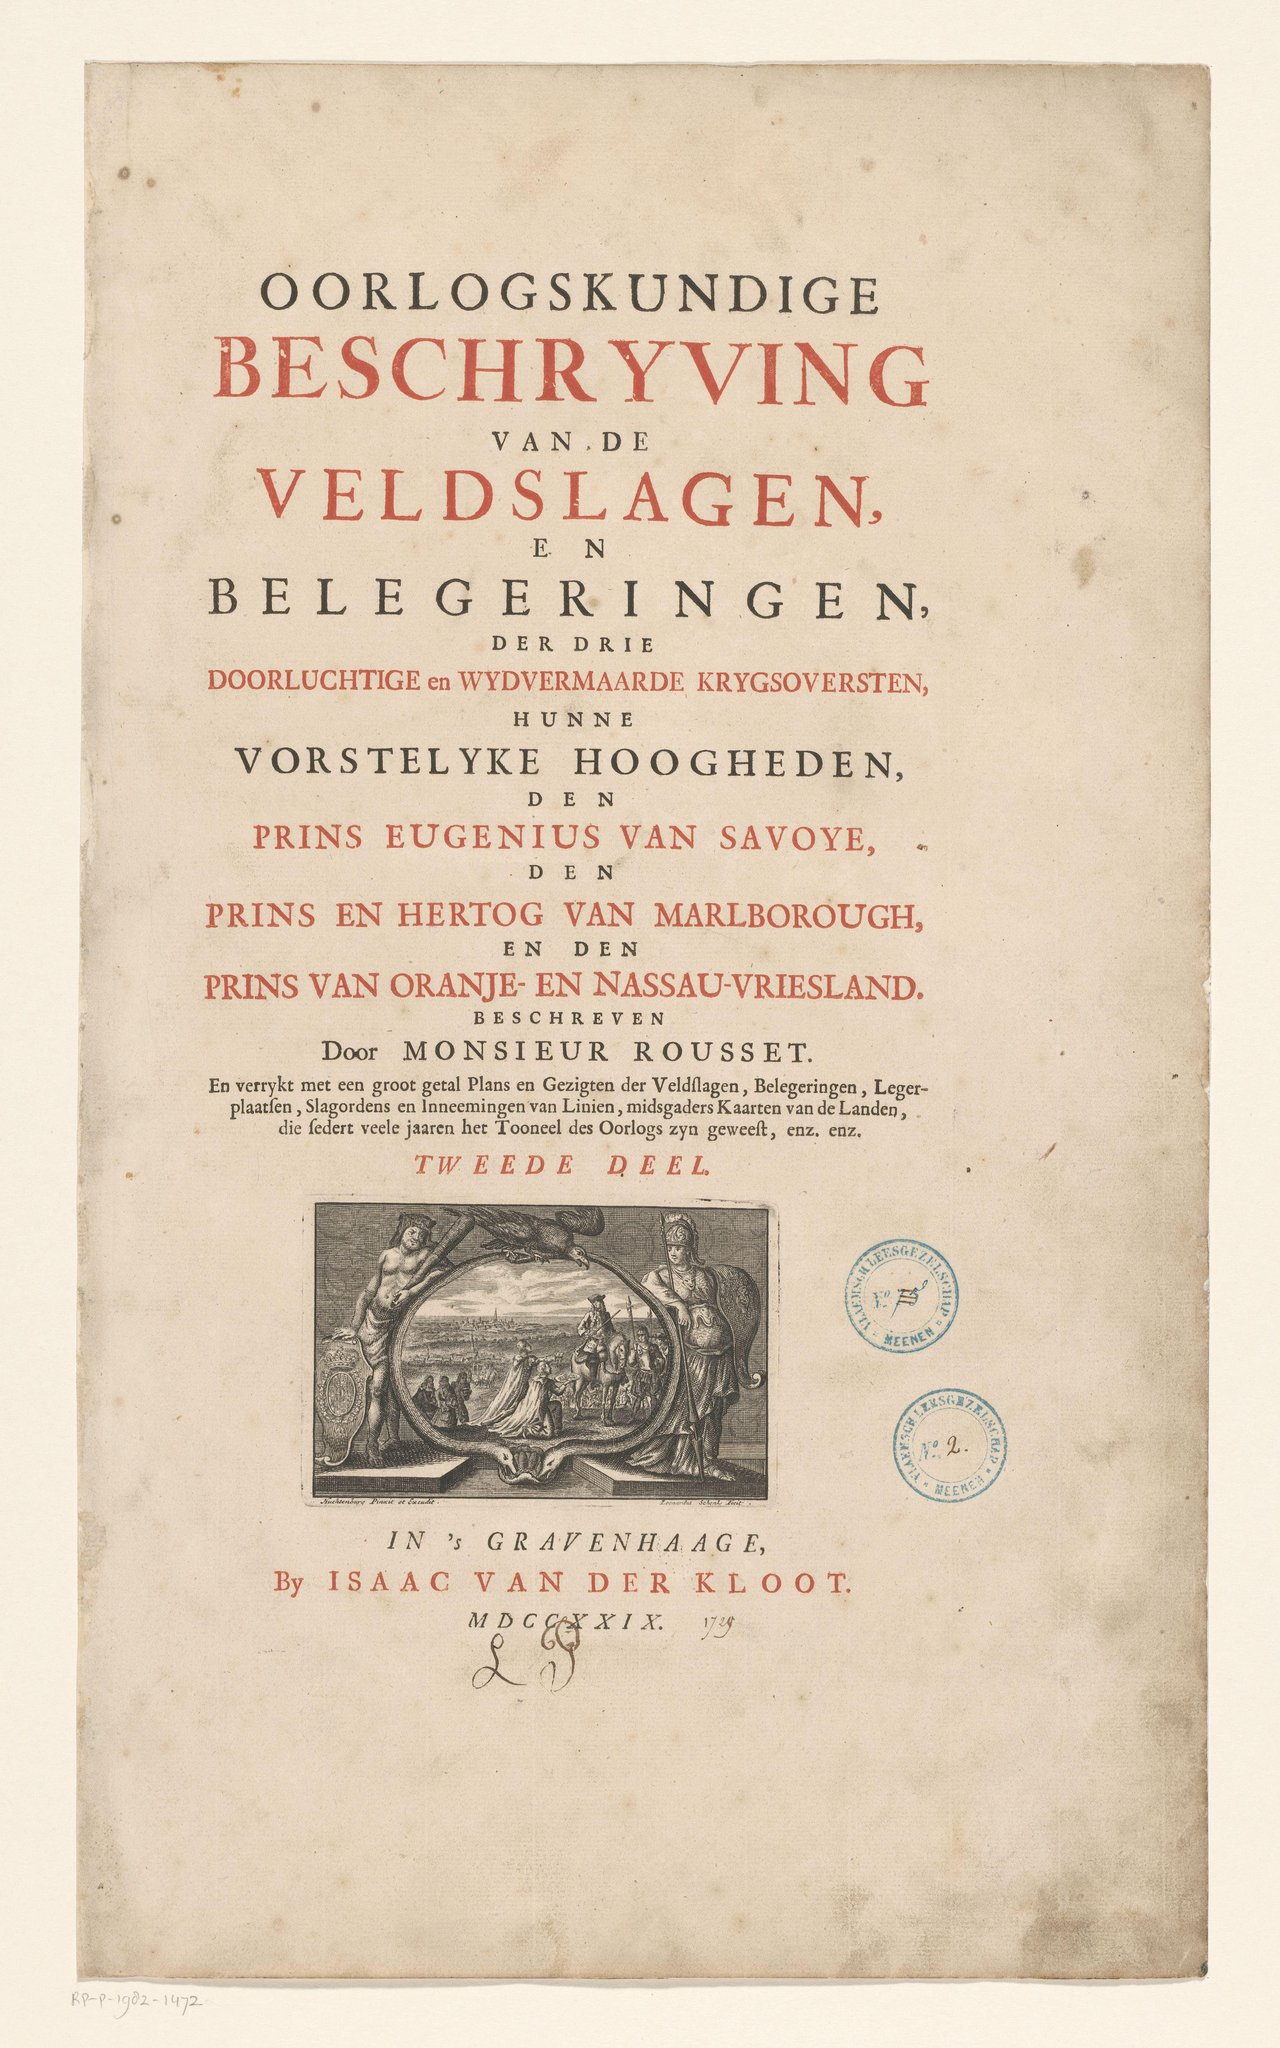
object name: print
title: Titelpagina met vignet uit: Rousset, Oorlogskundige Beschryving van de Veldslagen en Belegeringen, Tweede Deel (1729)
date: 1729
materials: paper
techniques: etching, letterpress printing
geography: northern netherlands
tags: paris, vienna, eugenius van savoye, surrender of keys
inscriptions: collector's mark: Lugt 2760, collector's mark: ‘Vlaemsch Leesgezelschap Meenen / No.’, collector's mark: Lugt 2228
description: Titelpagina voor: Rousset, Oorlogskundige beschryving van de veldslagen en belegeringen, der drie ... wydvermaarde krygsoversten... den Prins Eugenius van Savoye, den ... Hertog van Marlborough, en den Prins van Oranje en Nassau-Vriesland, Tweede Deel, 's-Gravenhage 1729. Blad met de titel in boekdruk in rood en zwart met een vignet waarop een veldheer de sleutels van een overwonnen stad aangeboden krijgt, in omlijsting van slangen, Hercules en Minerva.